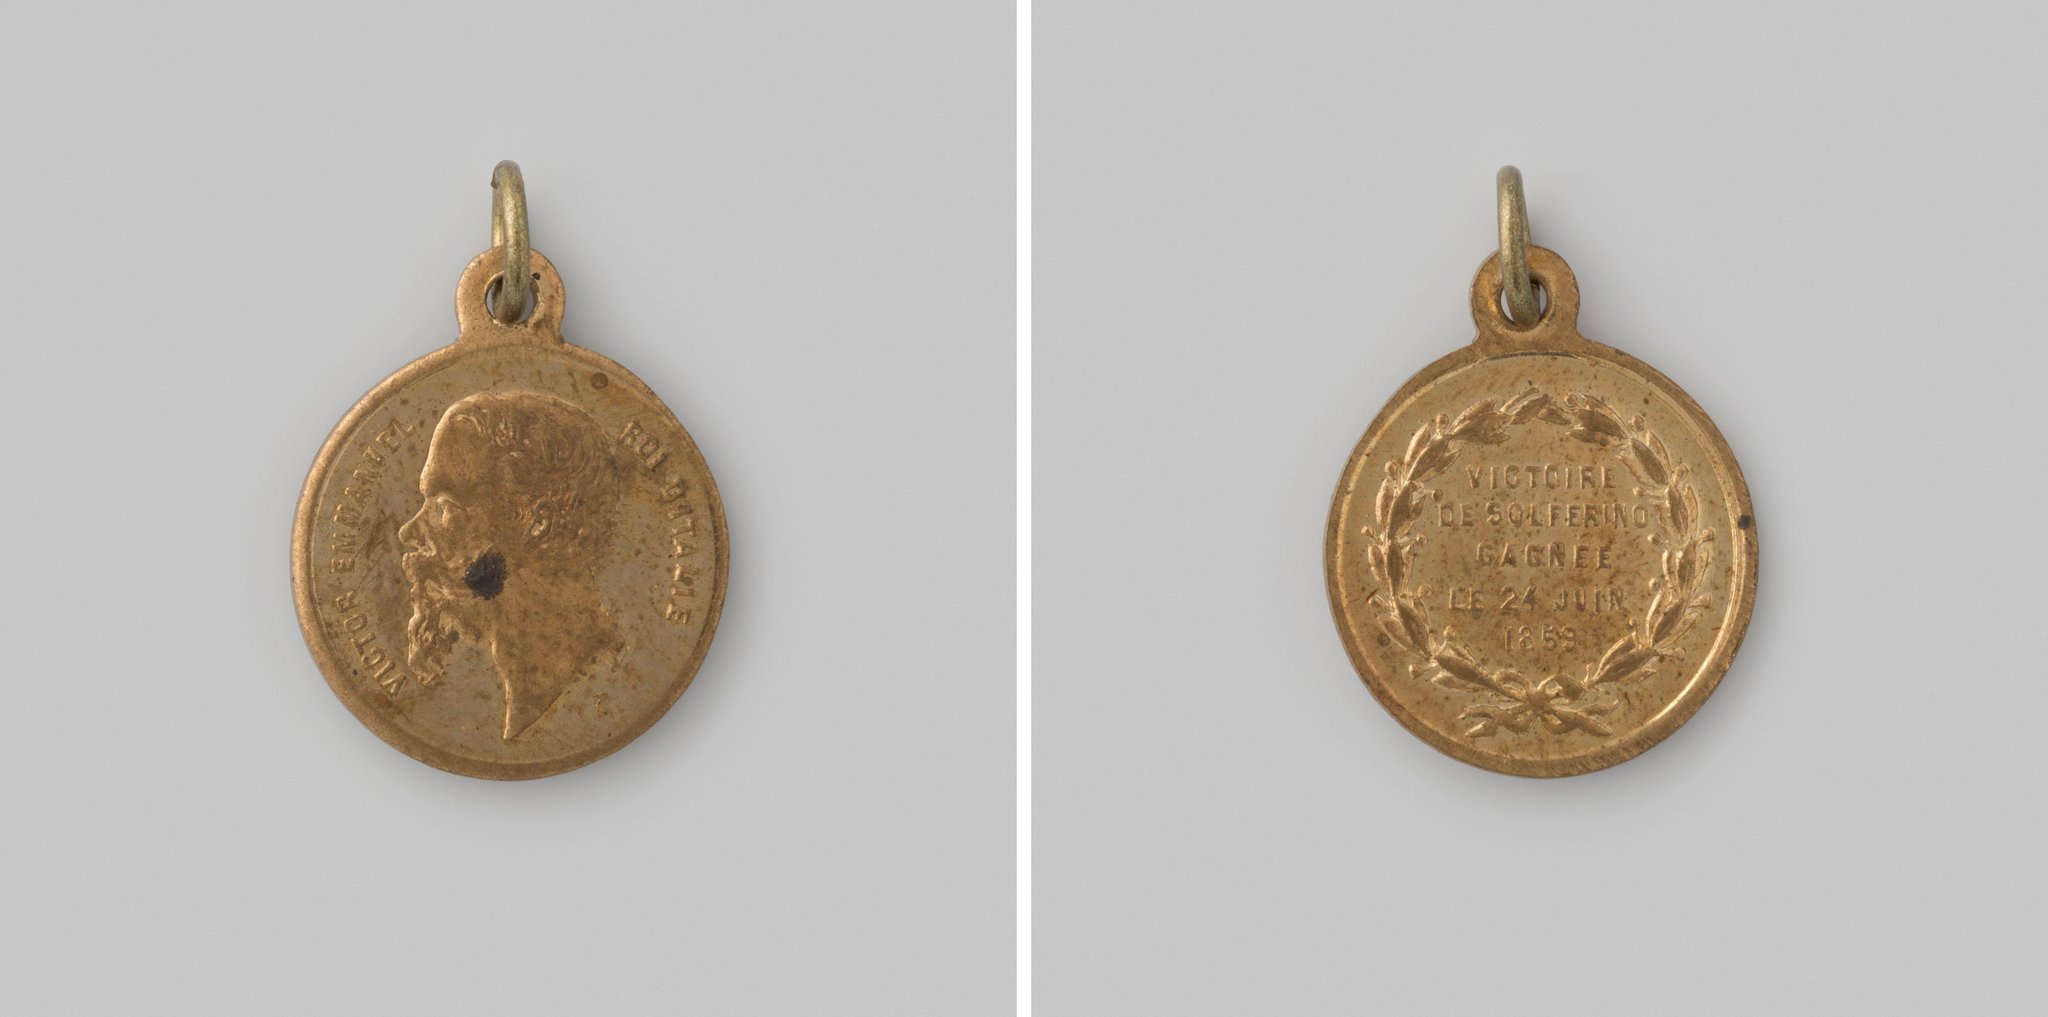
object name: history medal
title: Slag bij Solferino 1859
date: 1859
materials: brass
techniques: striking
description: Verguld penninkje met oog en draagring, op de voorzijde het portret van Koning Victor Emanuel naar links met omschrift, op de keerzijde vijf regels tekst tussen samengestrikte lauwertakken.